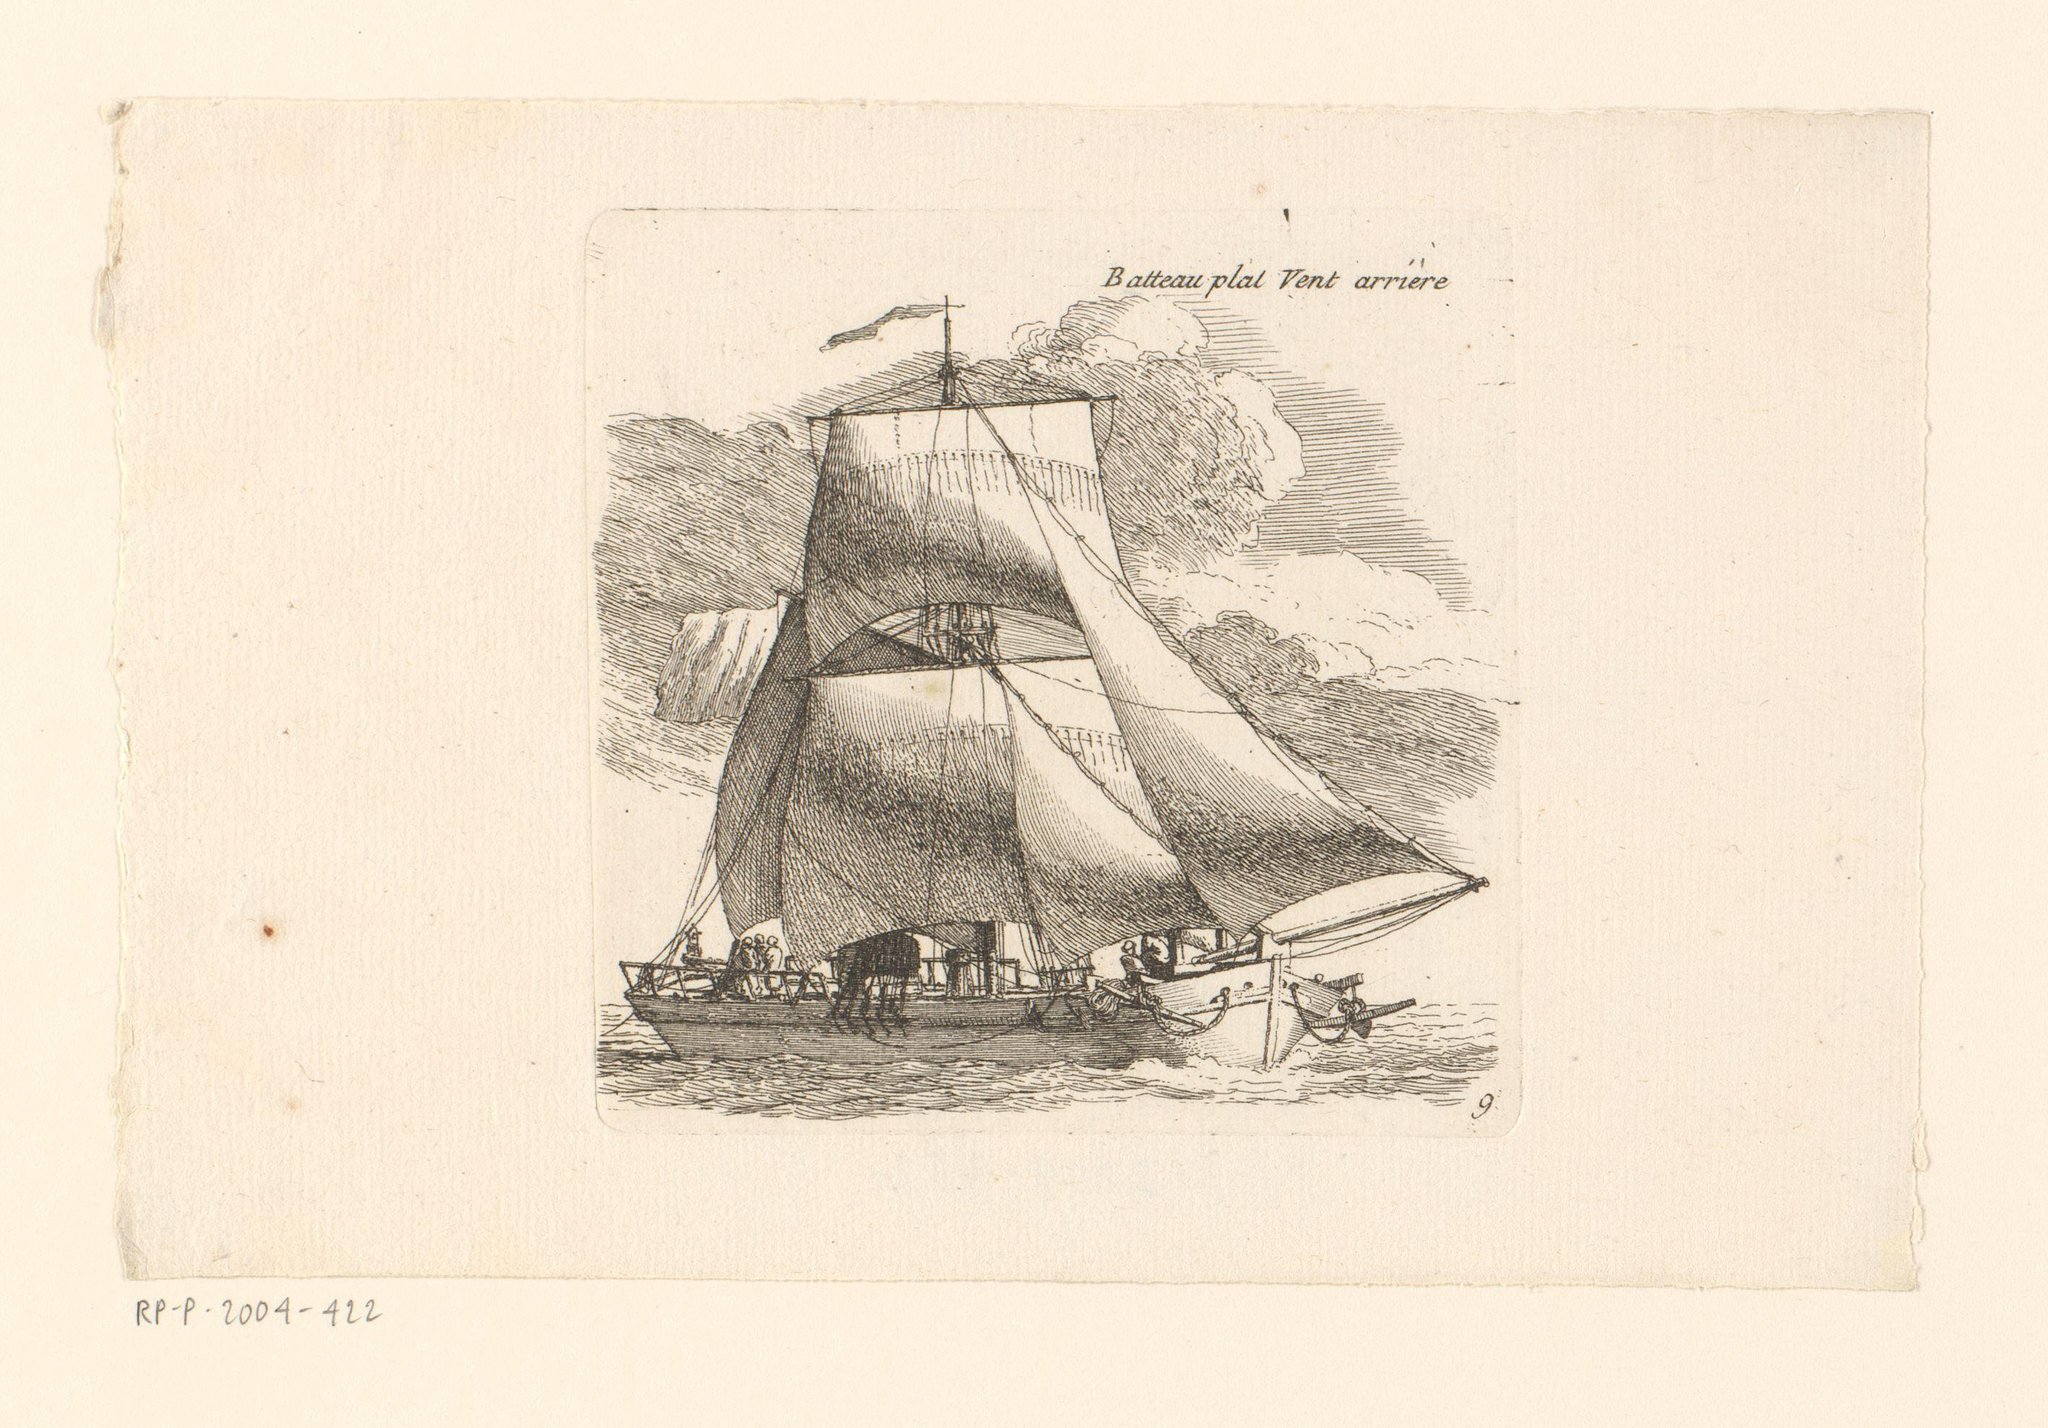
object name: print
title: Batteau plat vent arrière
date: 1738-1811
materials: paper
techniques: etching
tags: sailing-ship, sailing-boat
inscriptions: collector's mark: Lugt 2228, collector's mark: Lugt 2760